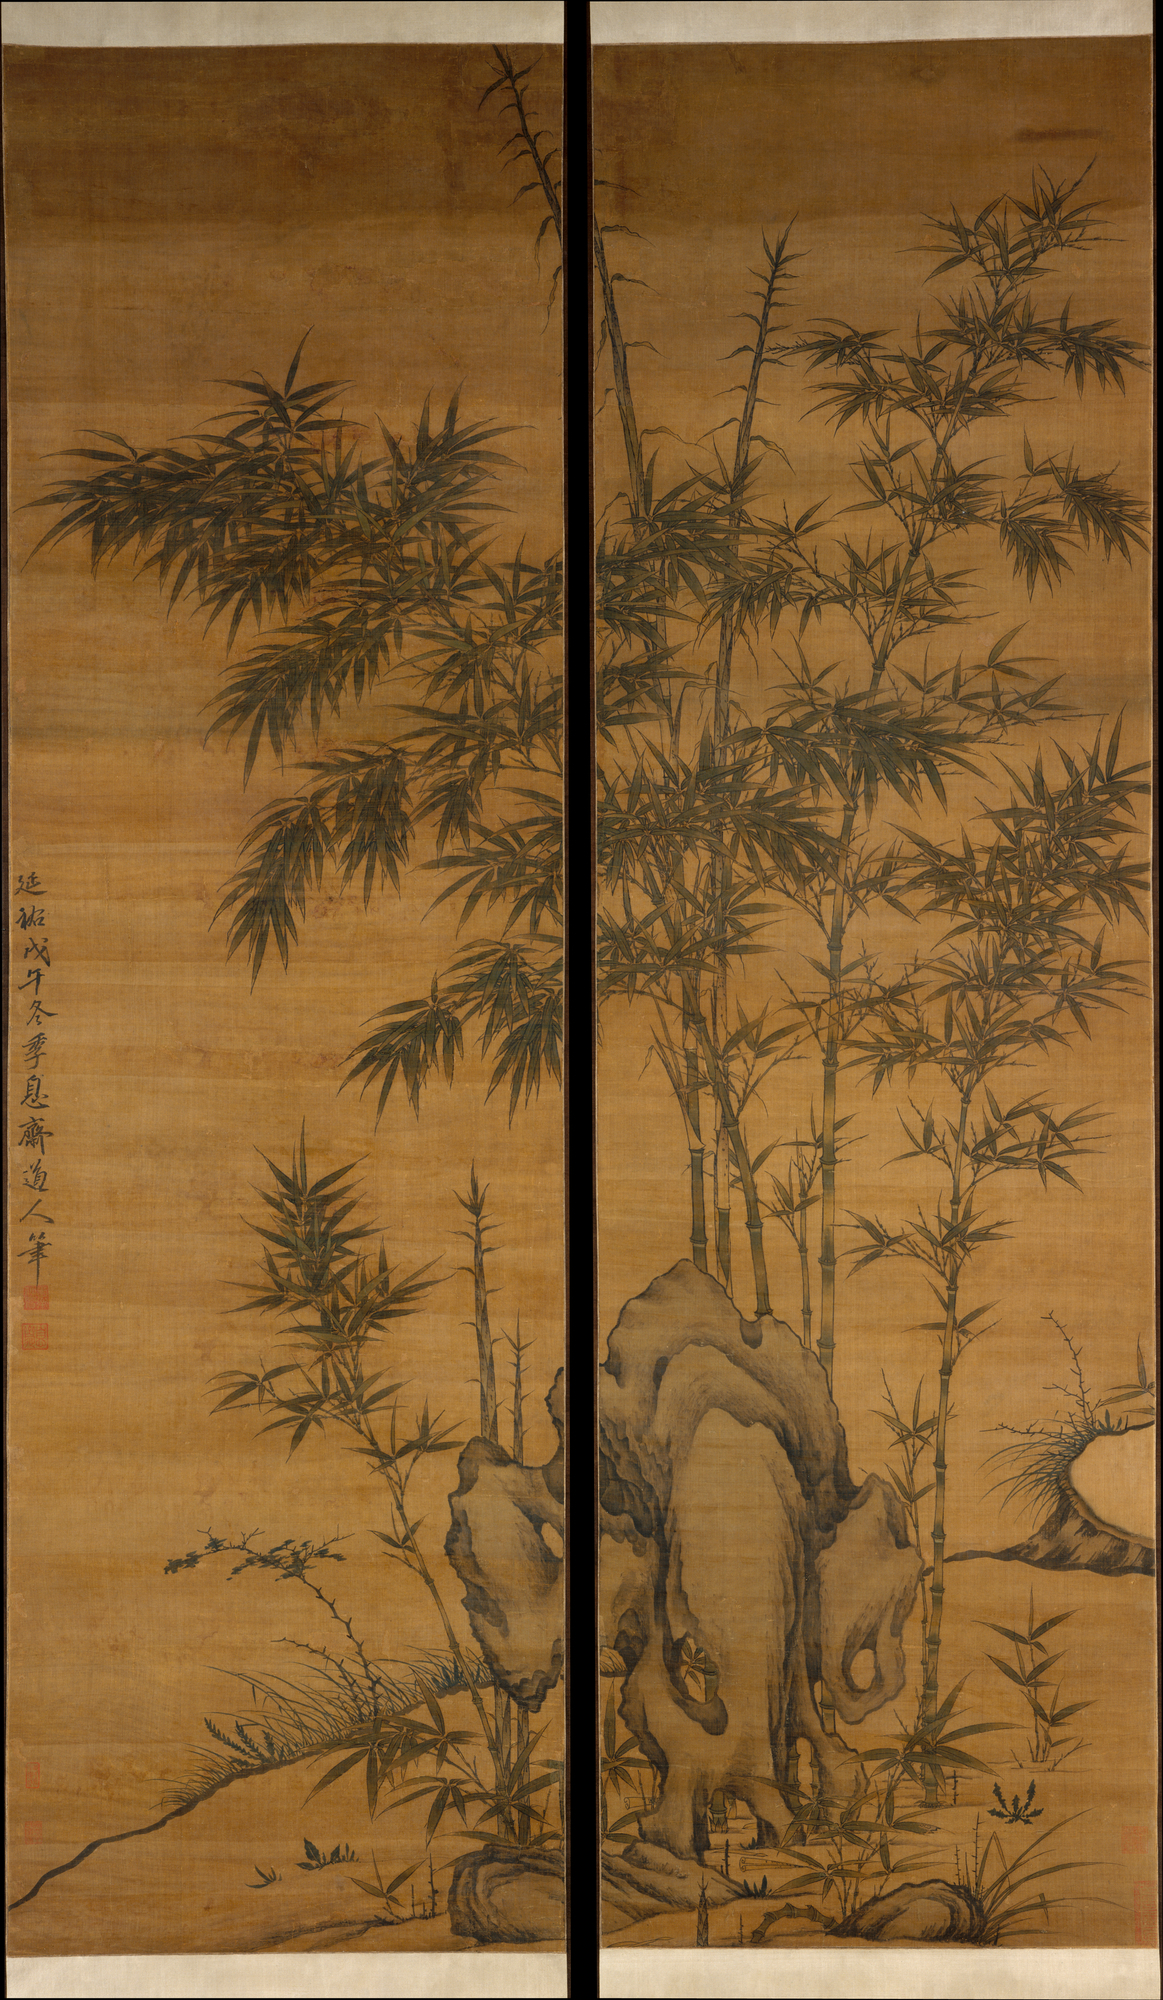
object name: hanging scroll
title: Bamboo and rocks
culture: chinese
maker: li kan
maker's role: artist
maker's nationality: chinese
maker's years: 1245-1320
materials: ink, silk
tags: bamboo